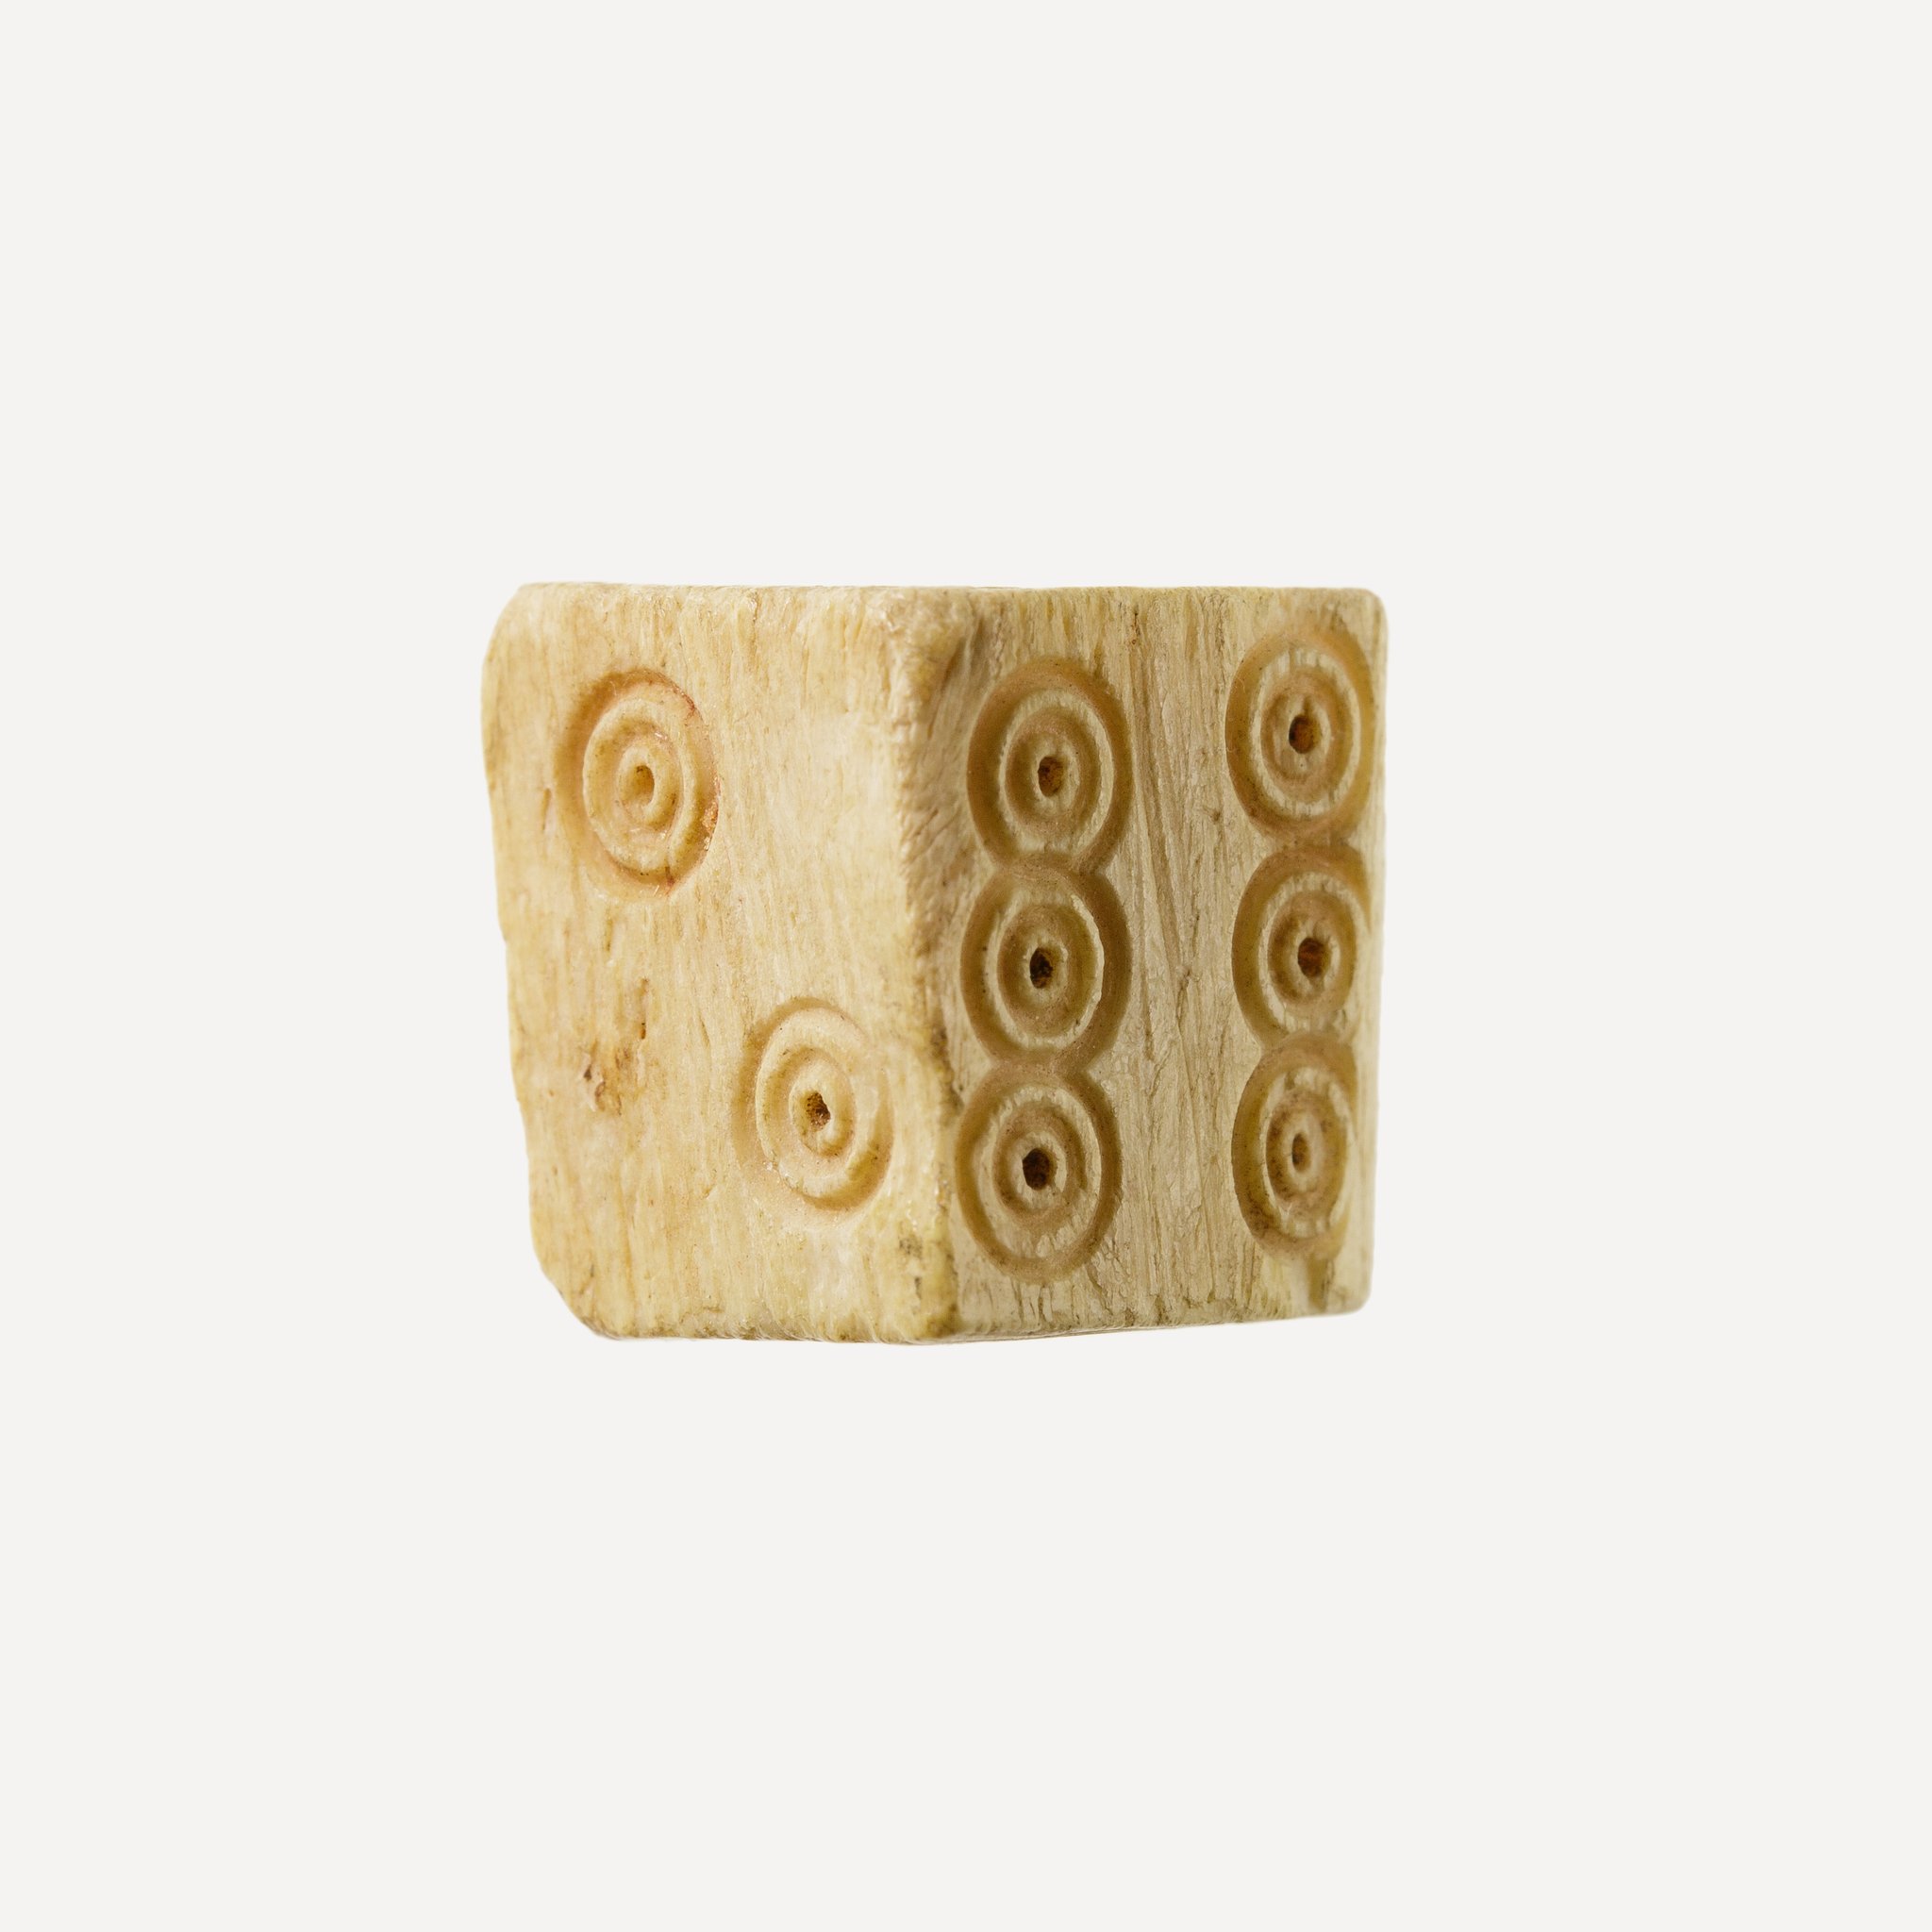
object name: dice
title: Die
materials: ivory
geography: egypt